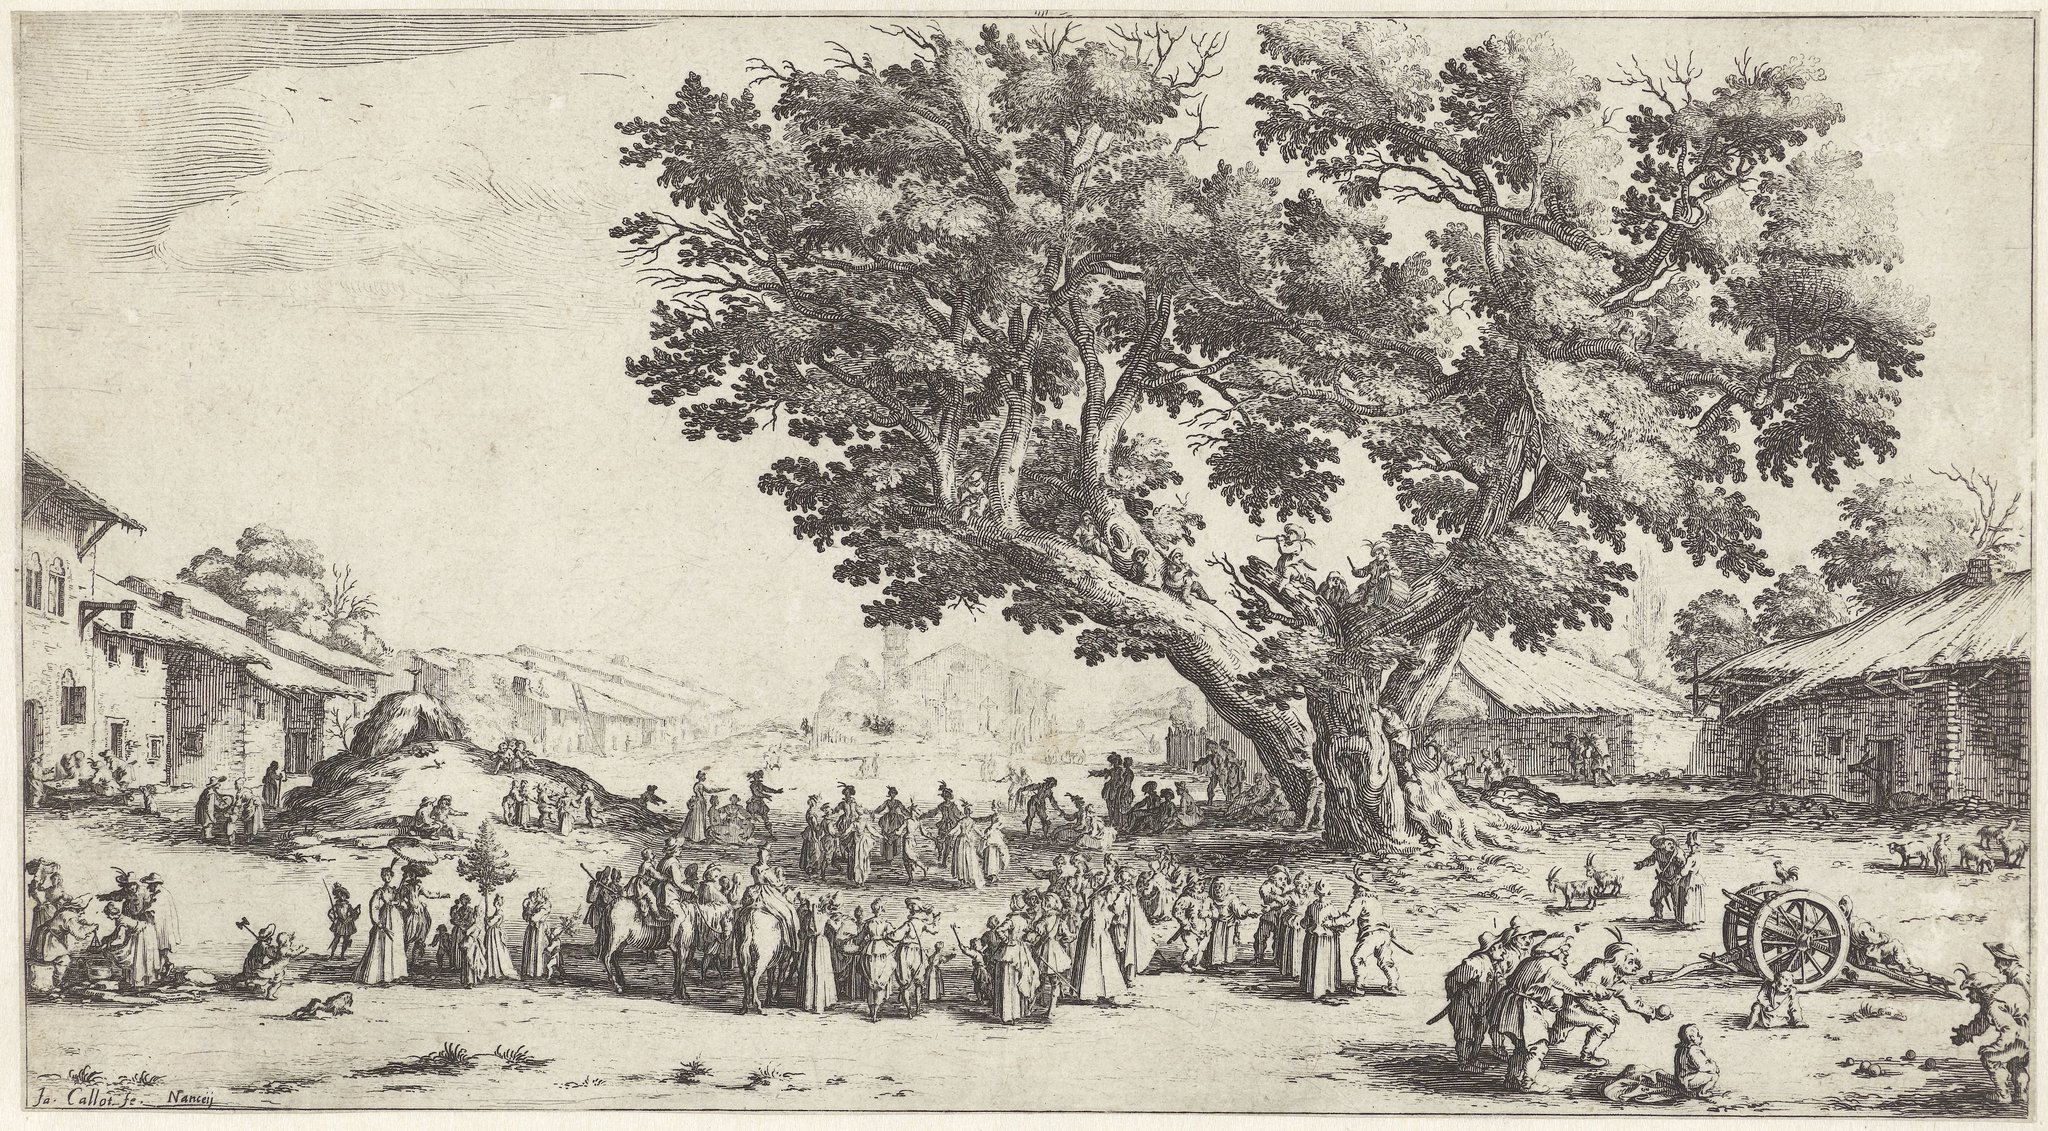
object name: print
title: Dorpsfeest te Gondreville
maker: jacques callot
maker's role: draughtsman, print maker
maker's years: 1592-1635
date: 1625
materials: paper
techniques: etching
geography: nancy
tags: public festivities, 'jeu de boules', group dancing, village square, place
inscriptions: collector's mark: Lugt 240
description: Bij een grote boom op een dorpsplein worden allerlei activiteiten ontplooid: een groepje dames en heren danst hand in hand, een aantal mannen speelt jeu de boules, een stel meisjes biedt een meiboom aan een jong paar aan.